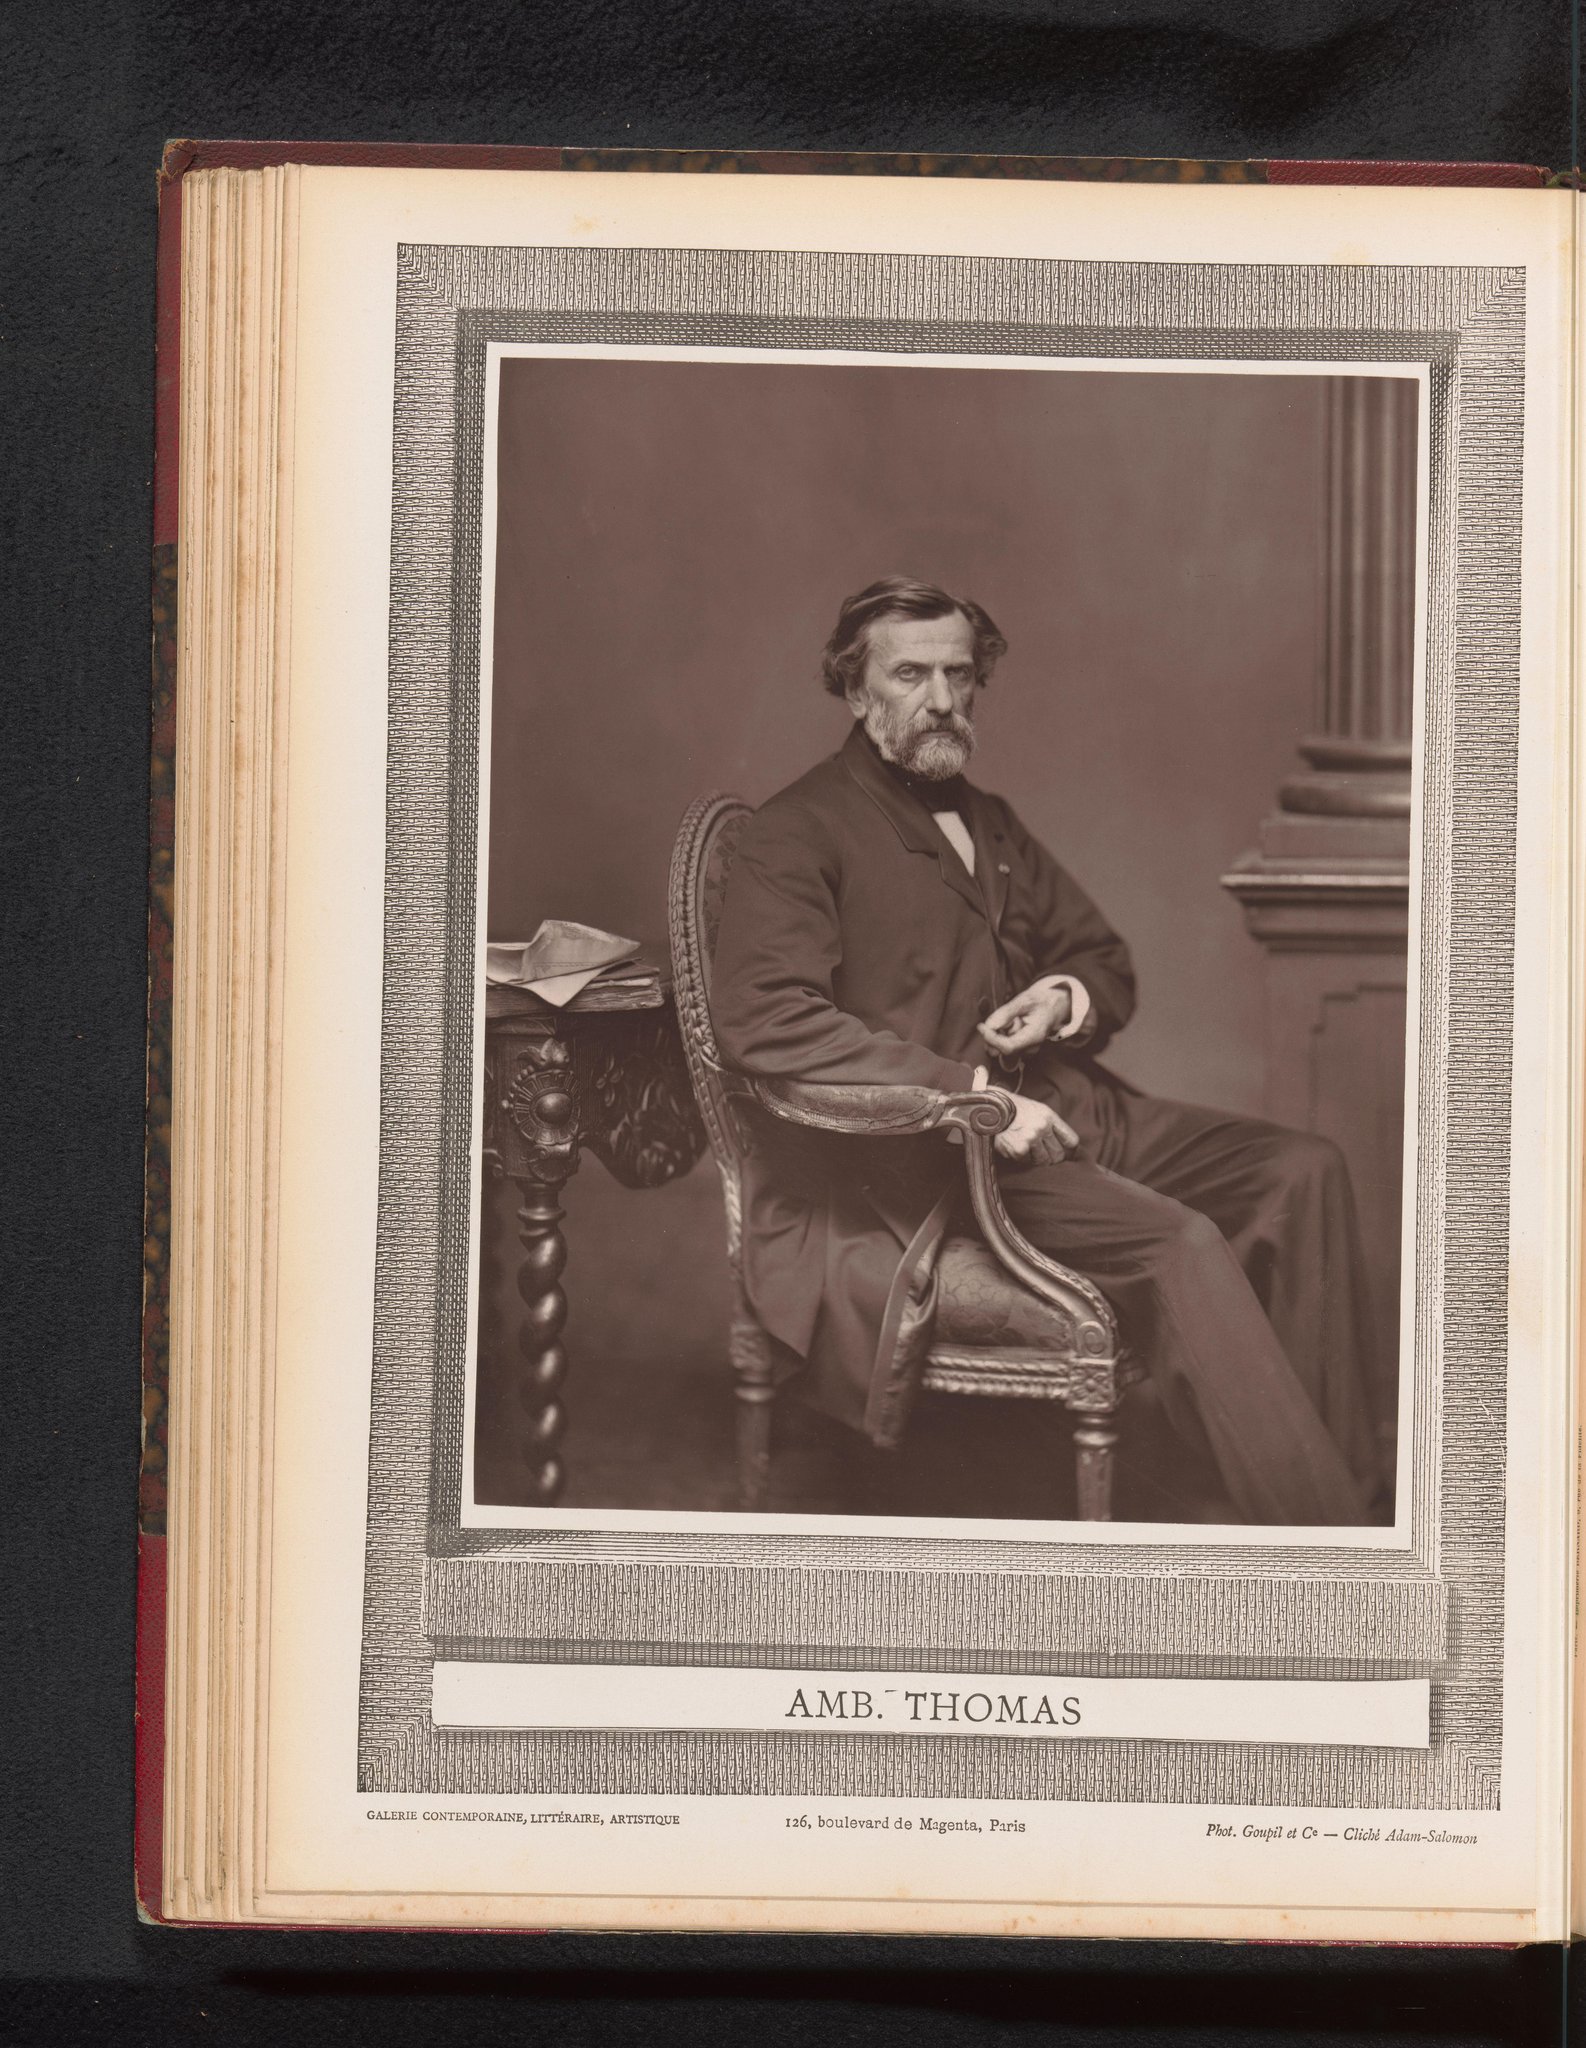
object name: photomechanical print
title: Amb. Thomas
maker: antoine-samuel adam-salomon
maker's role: sculptor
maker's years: 1818-1881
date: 1871-1876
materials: paper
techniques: woodburytype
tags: ambroise thomas, adult man, historical persons